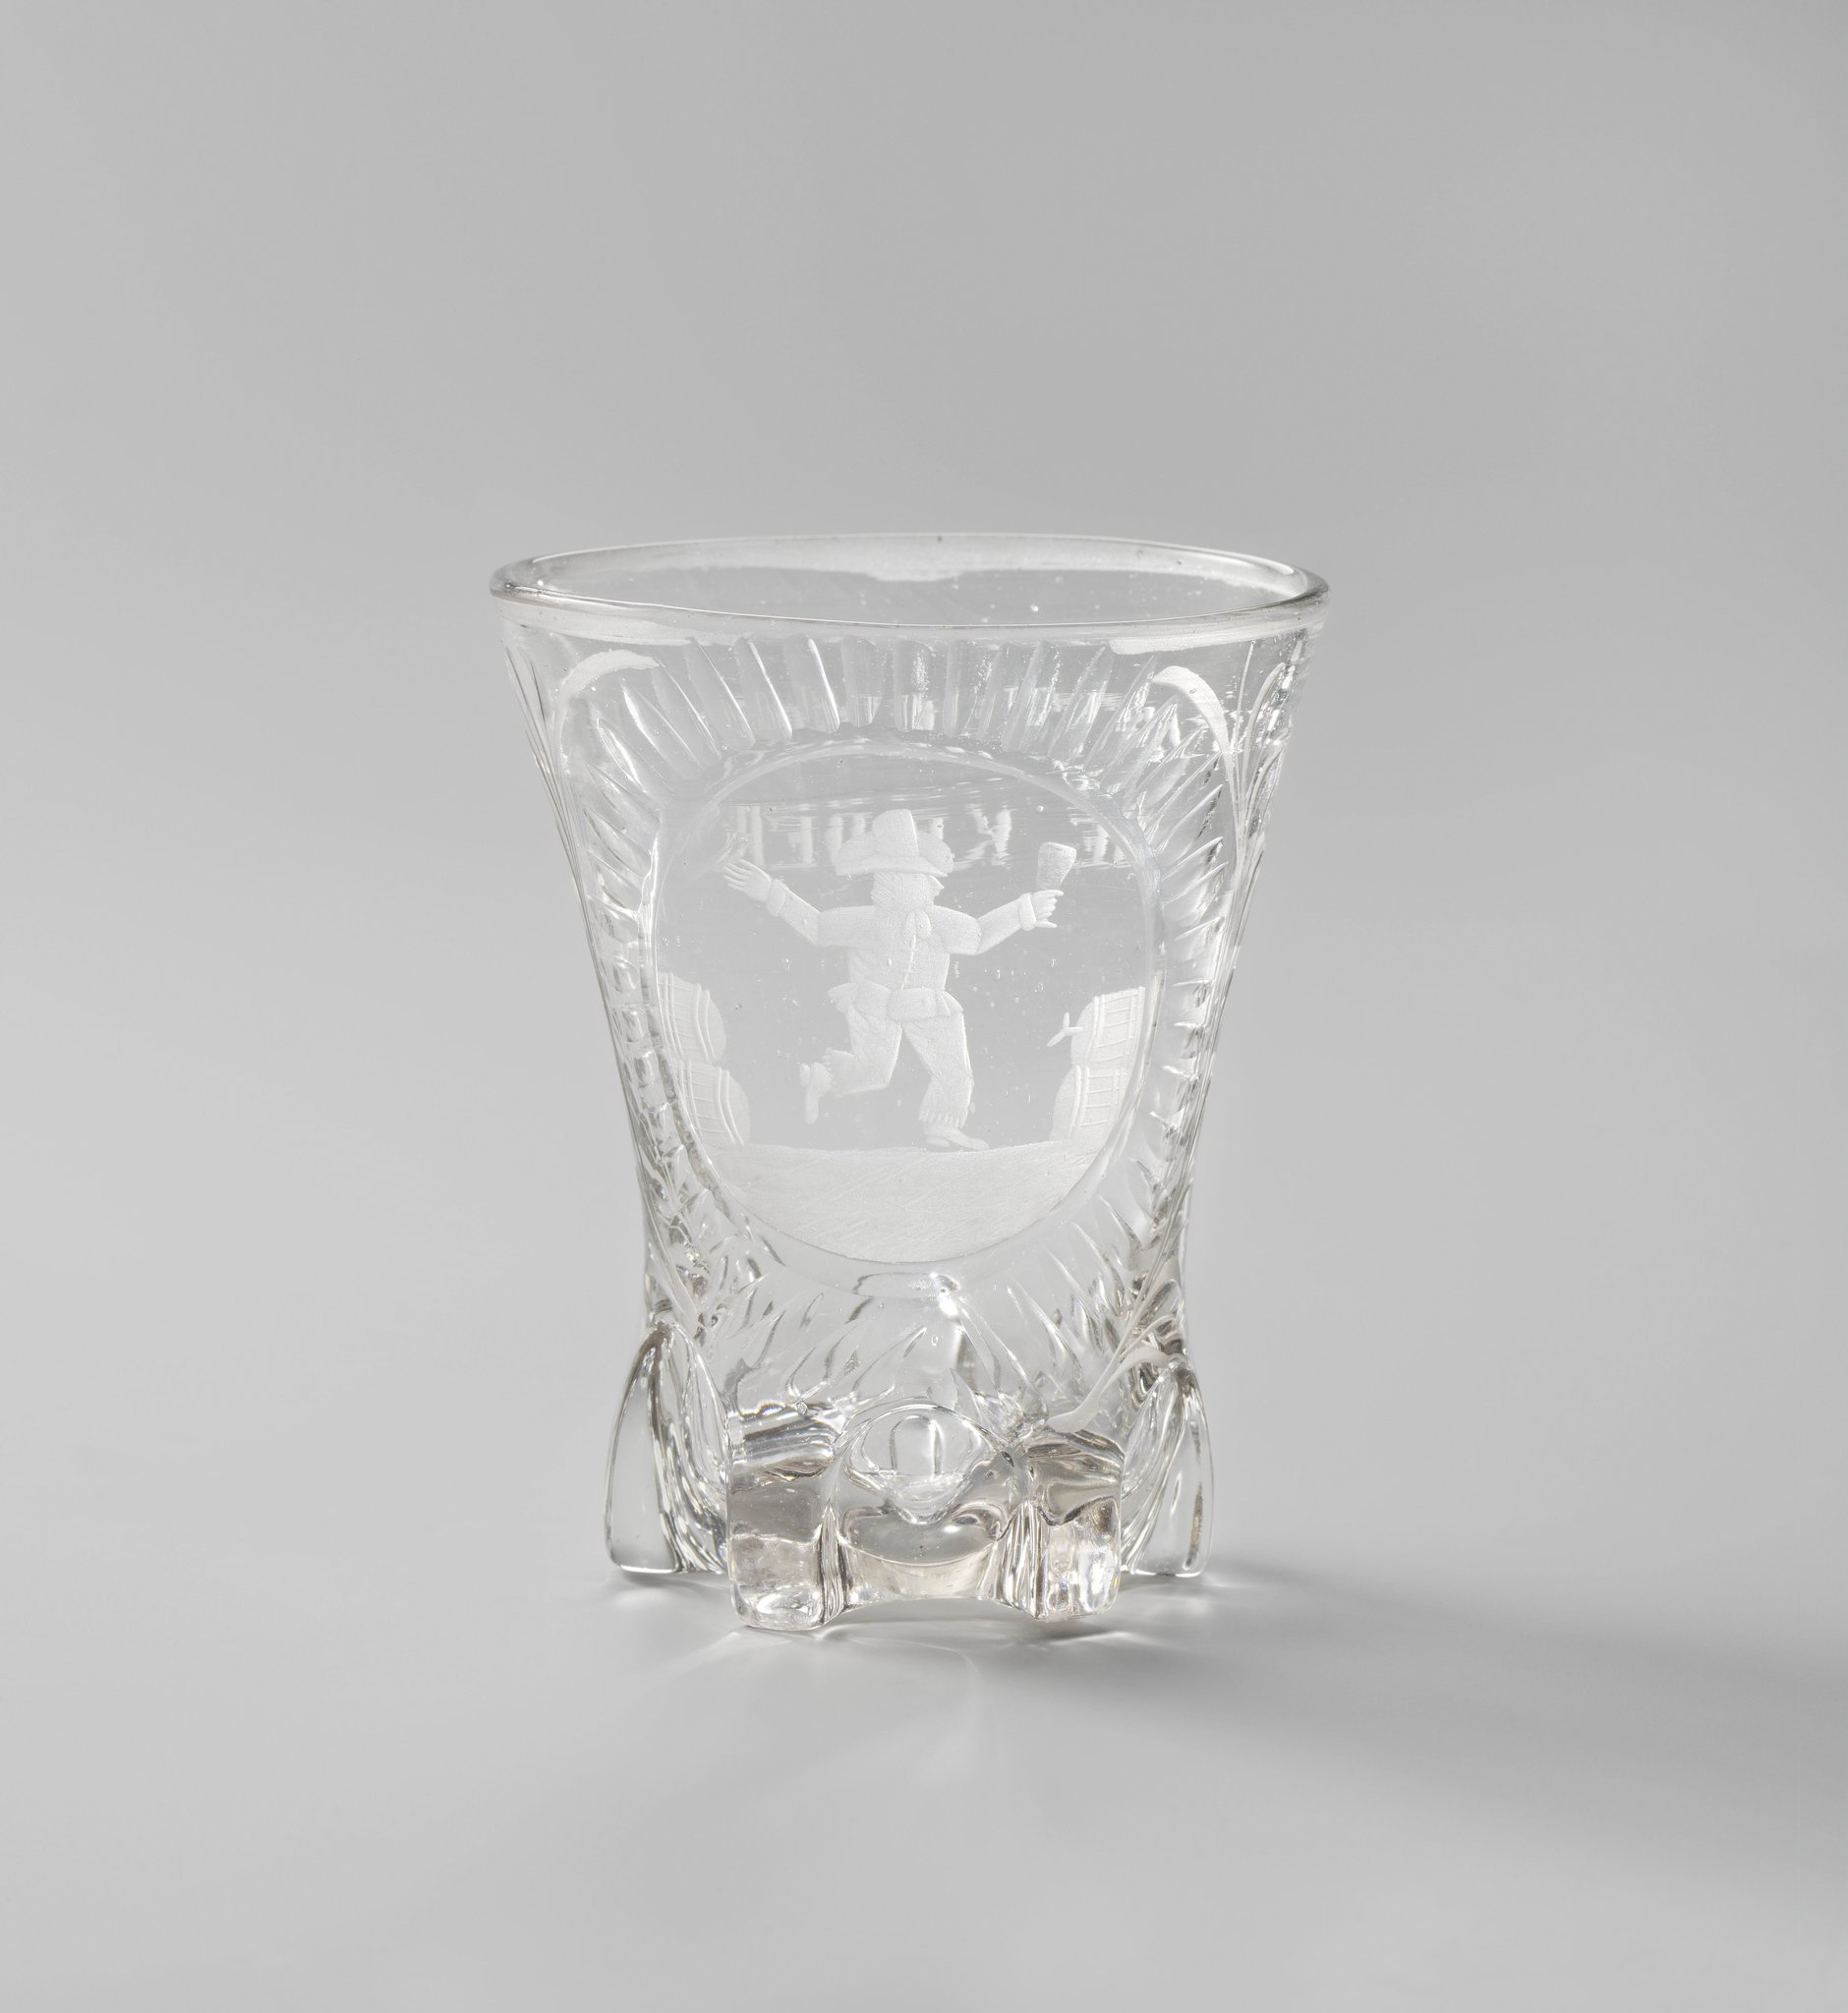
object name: cup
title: Beaker with a man between barrels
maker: Anonymous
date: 1725-1775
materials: glass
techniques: glassblowing, grinding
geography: germany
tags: wine-cellar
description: translation of inscription: Long live Hensel in / the cellar